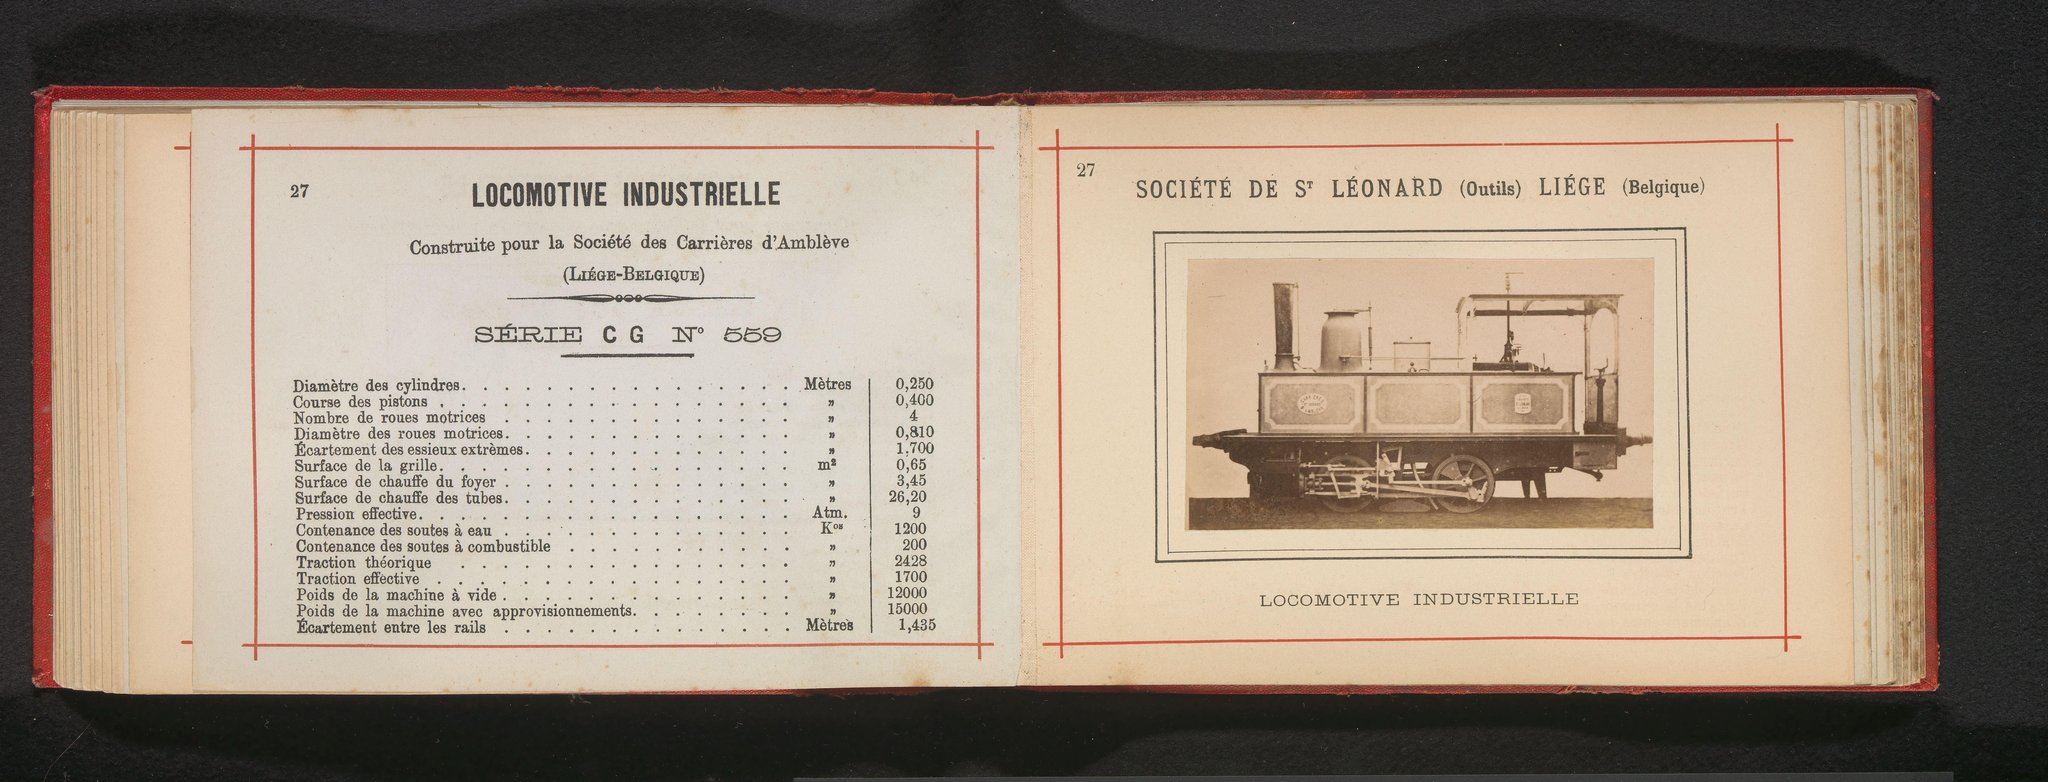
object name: photograph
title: Locomotief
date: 1880-1885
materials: photographic support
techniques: albumen print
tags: locomotive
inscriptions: inscription: ‘Société de St. Léonard (Outils) Liége (Belgique)’